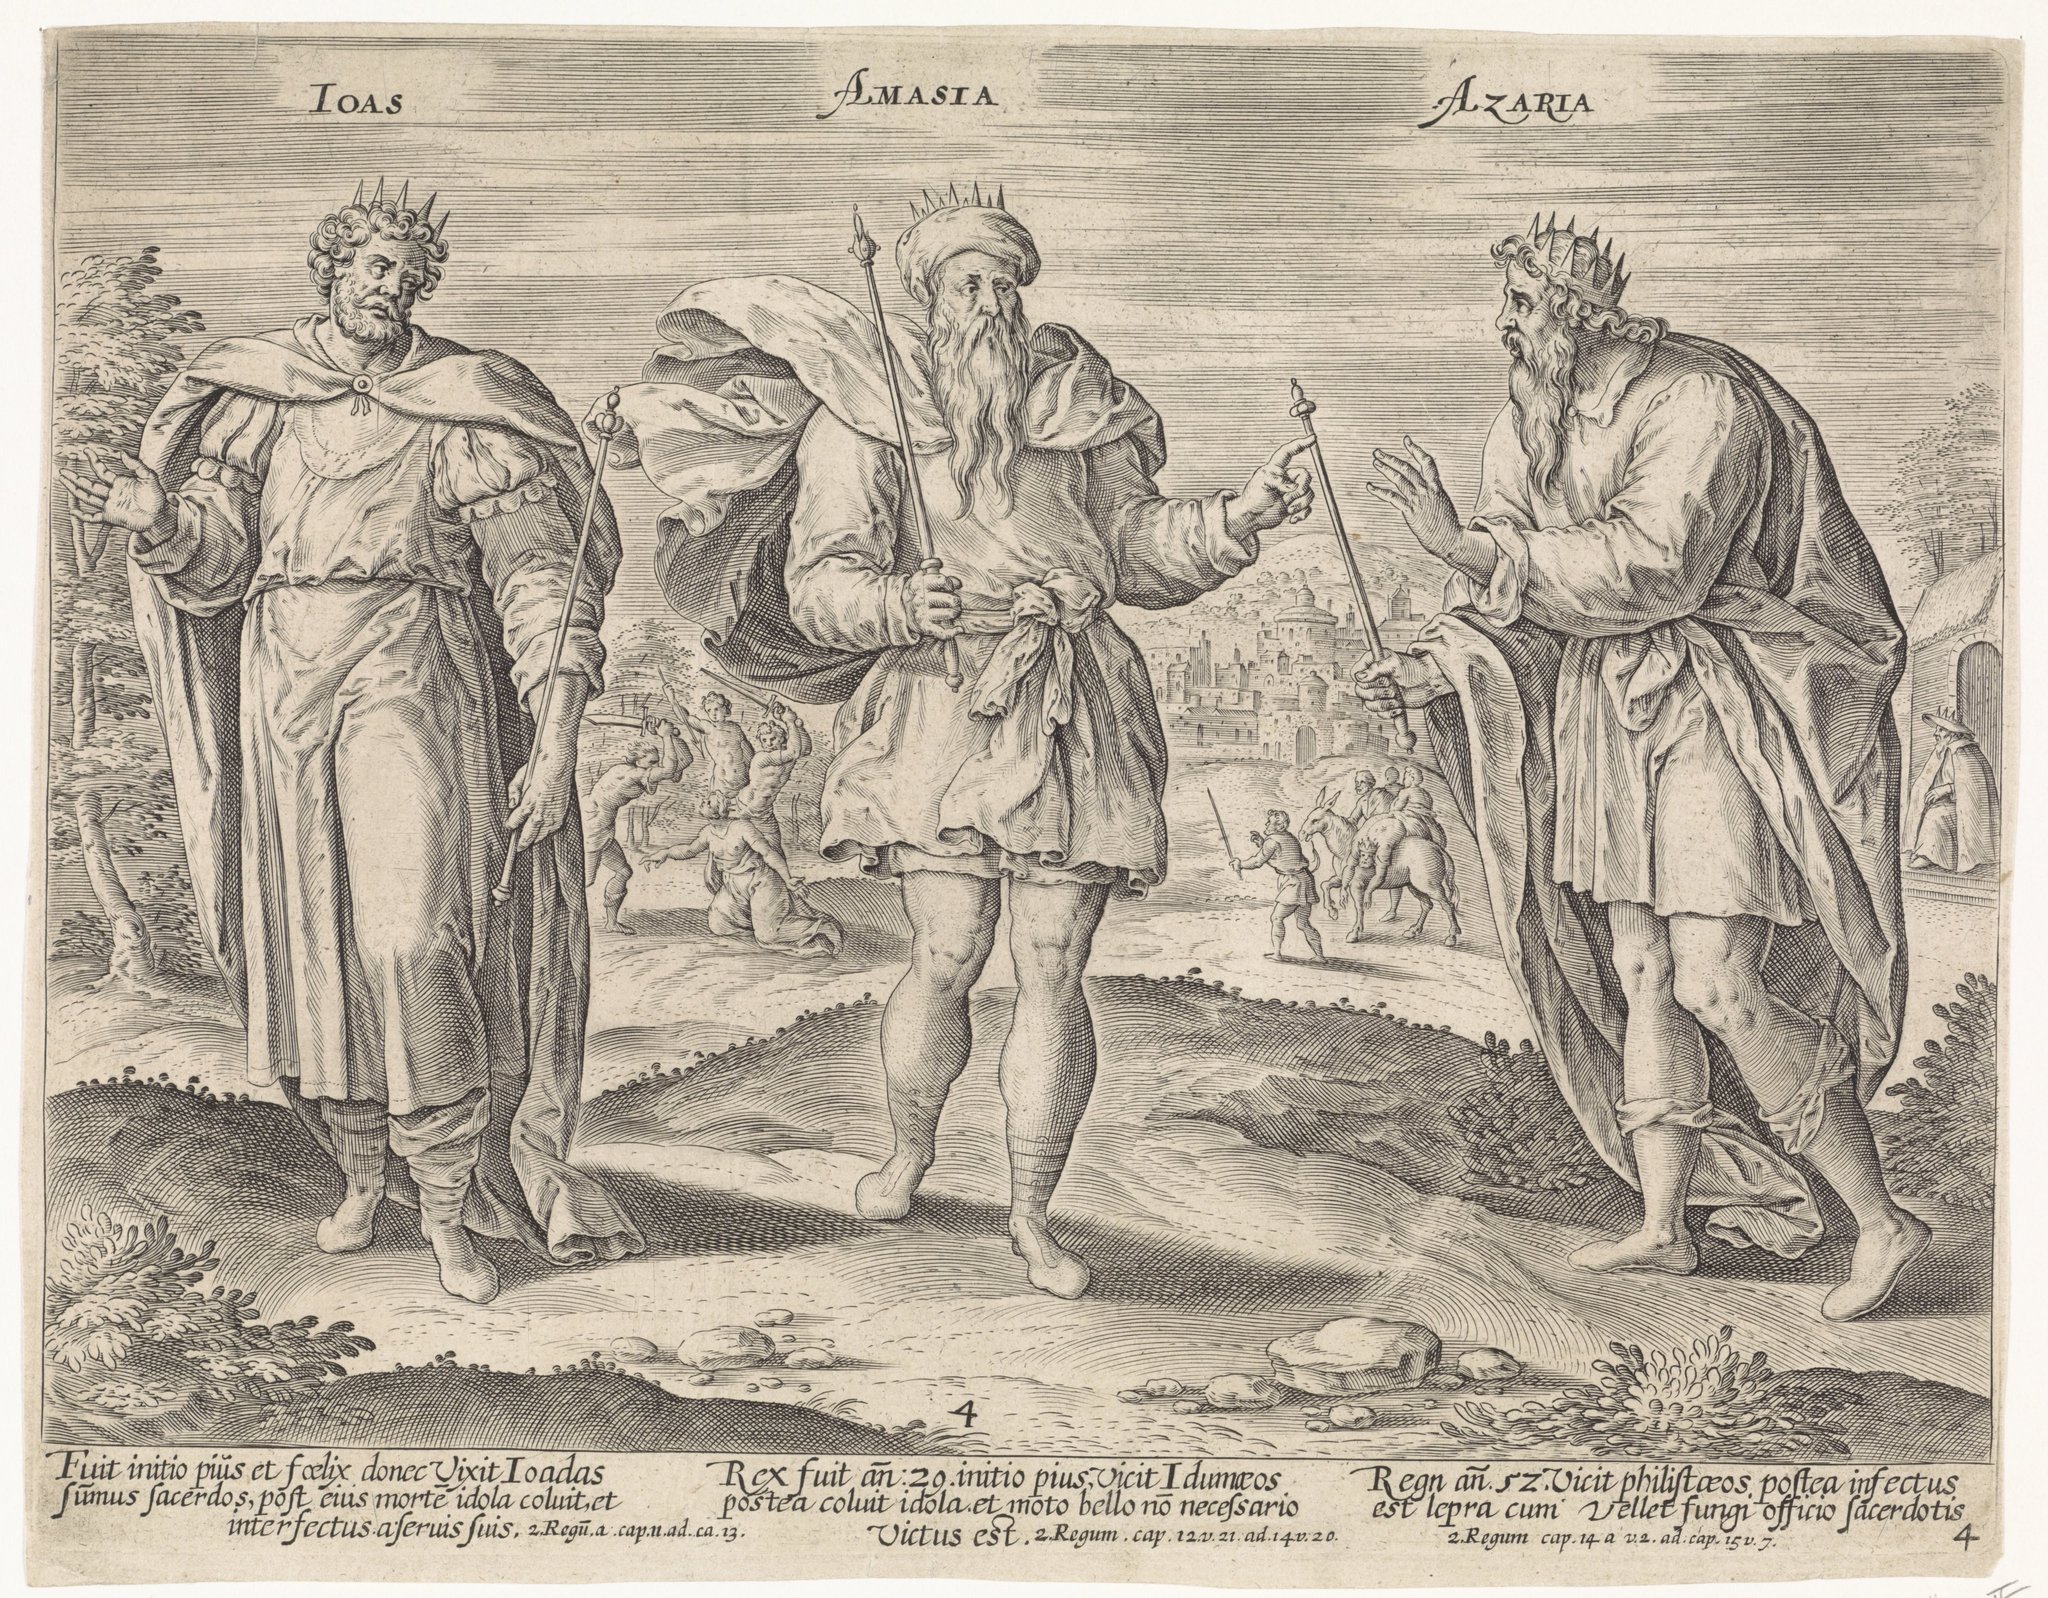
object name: print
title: Koningen van Juda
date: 1585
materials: paper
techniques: engraving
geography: amsterdam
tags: death of athalia: she is seized by soldiers, brought to the palace and killed at the horse gate, story of joash, son of ahaziah, king of judah (2 kings 11:4 - 12:21; 2 chronicles 23-24), amaziah is assassinated in lachish; his body is carried back to jerusalem on a horse, story of uzziah (azariah), son of amaziah, king of judah (2 kings 15:1-7; 2 chronicles 26), story of amaziah, son of joash, king of judah (2 kings 14:1-21; 2 chronicles 25), kings of israel and judah ~ the old testament (not in biblical context)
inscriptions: collector's mark: Lugt 2228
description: De koningen Joas, Amasja en Azarja. Op de achtergrond enkele belangrijke gebeurtenissen uit hun leven. Links op de achtergrond wordt Joas' voorganger koningin Atalja ter dood gebracht. Midden op de achtergrond wordt de vermoorde koning Amasja te paard naar Jeruzalem gebracht. Rechts op de achtergrond zit koning Azarja bedekt bij een poort. Hij leefde in afzondering omdat hij leed aan huidvraat. Onder de voorstelling verwijzingen naar de Bijbelteksten in het Latijn.